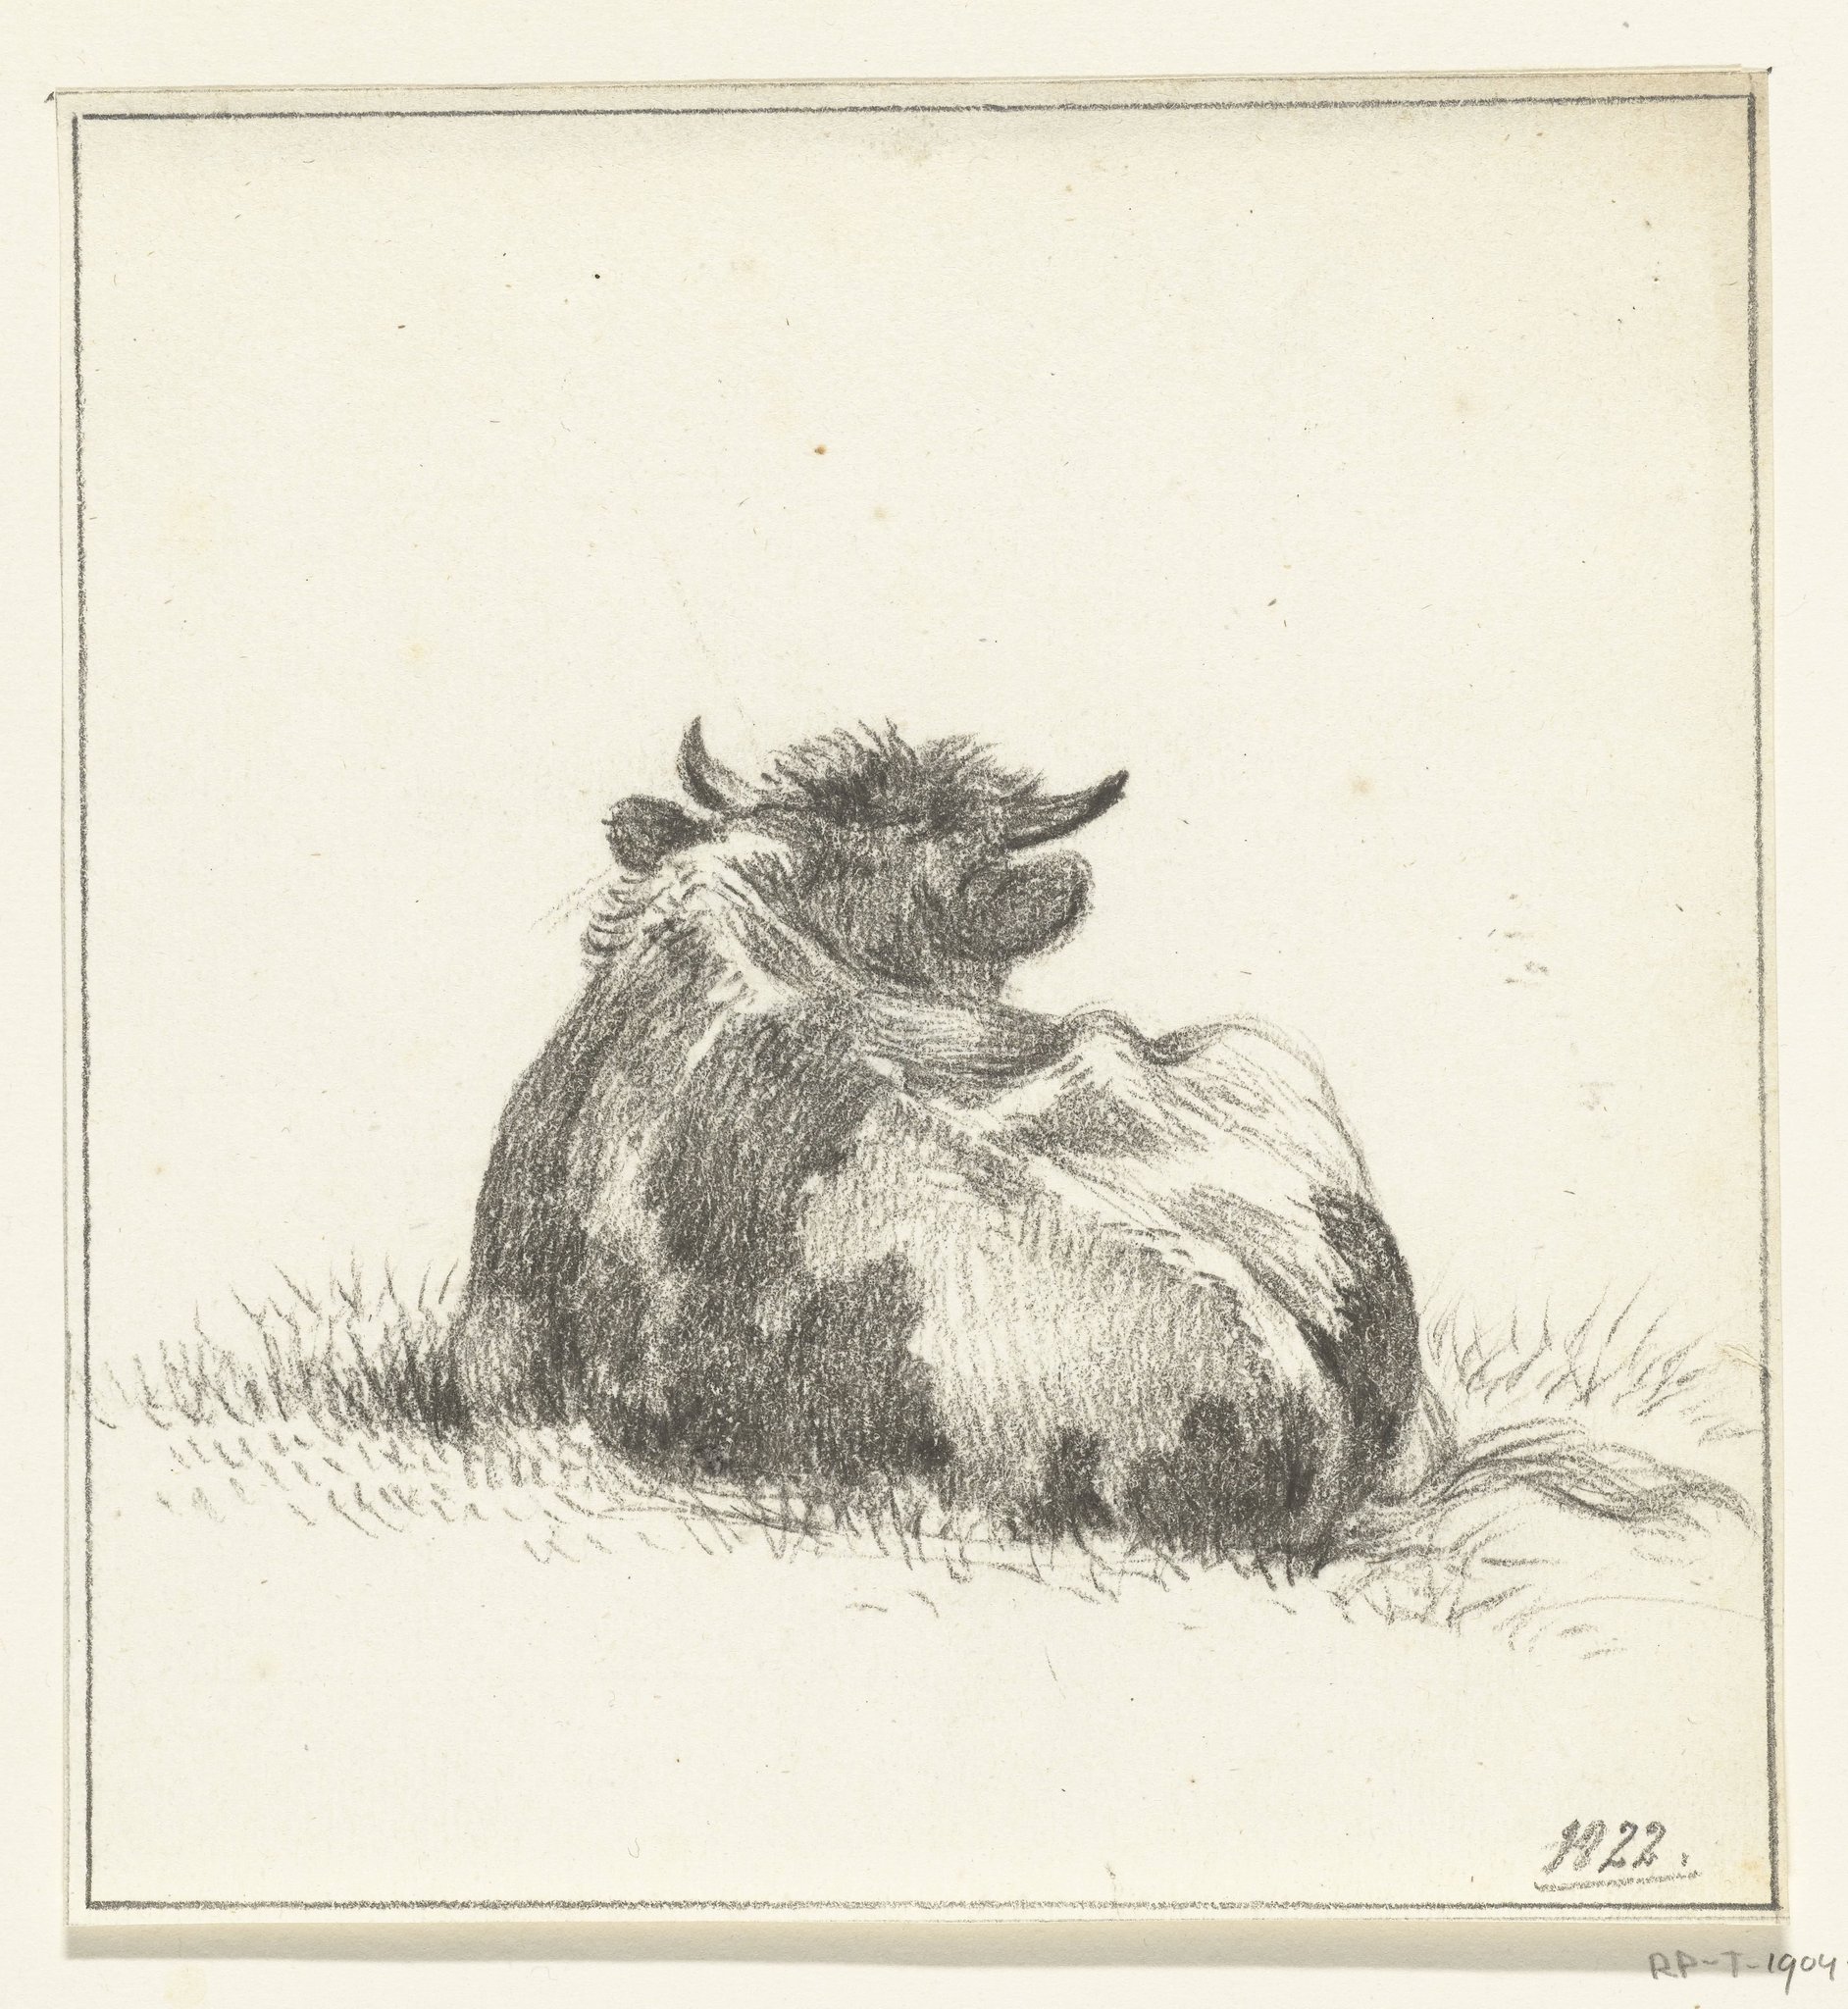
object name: drawing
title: Liggende koe, van achteren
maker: jean bernard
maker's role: draughtsman, print maker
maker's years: 1765-1833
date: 1822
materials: chalk, paper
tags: cow